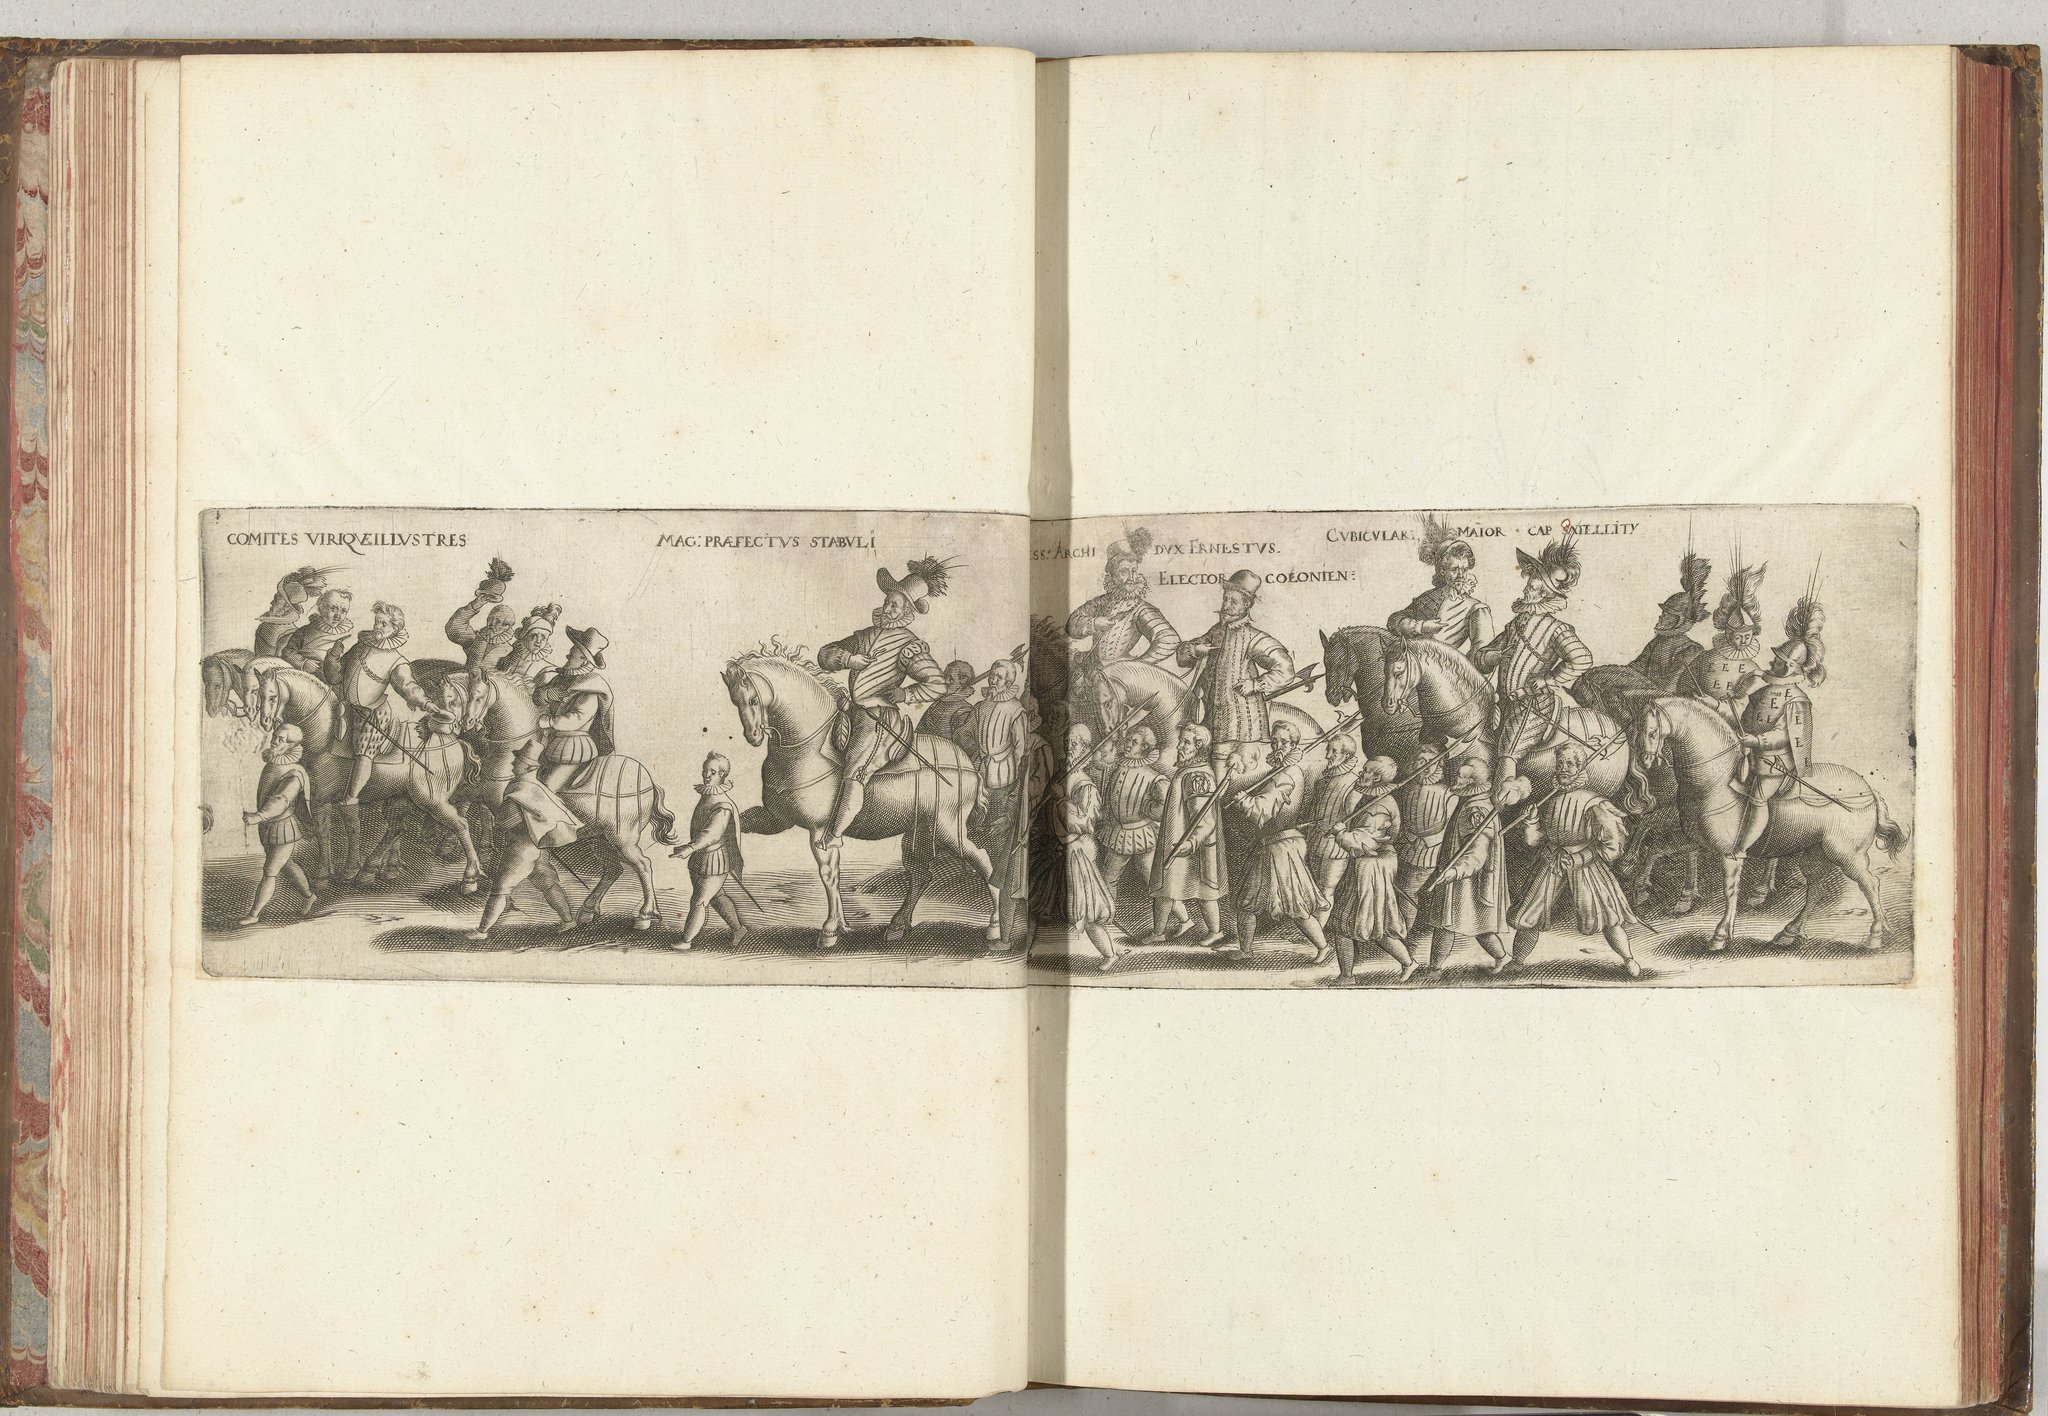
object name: print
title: De stoet met aartshertog Ernst bij de intocht te Brussel (deel 4), 1594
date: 1594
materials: paper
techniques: engraving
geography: southern netherlands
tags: vienna, brussels, triumphal entry and public reception, pageant, 'entrée solennelle', 'joyeuse entrée'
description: De stoet met aartshertog Ernst bij de intocht te Brussel (deel 4), in het midden de aartshertog te paard naast de keurvorst van Keulen. Feestelijke intocht van aartshertog Ernst als gouverneur der Nederlanden gehouden te Brussel op 30 januari 1594. Onderdeel van de beschrijving van deze intocht Descriptio et explicatio pegmatum, arcuum spectaculorum quae Bruxellae Brabant. pridie Cal. Febr. Ao. 1594 exhibita fuere, sub ingressum ... Ernesti ... Archiducis Austriae ... pro Philippo II. Belgicae ditionis gubernatore, J. Mommaert, Brussel 1594.